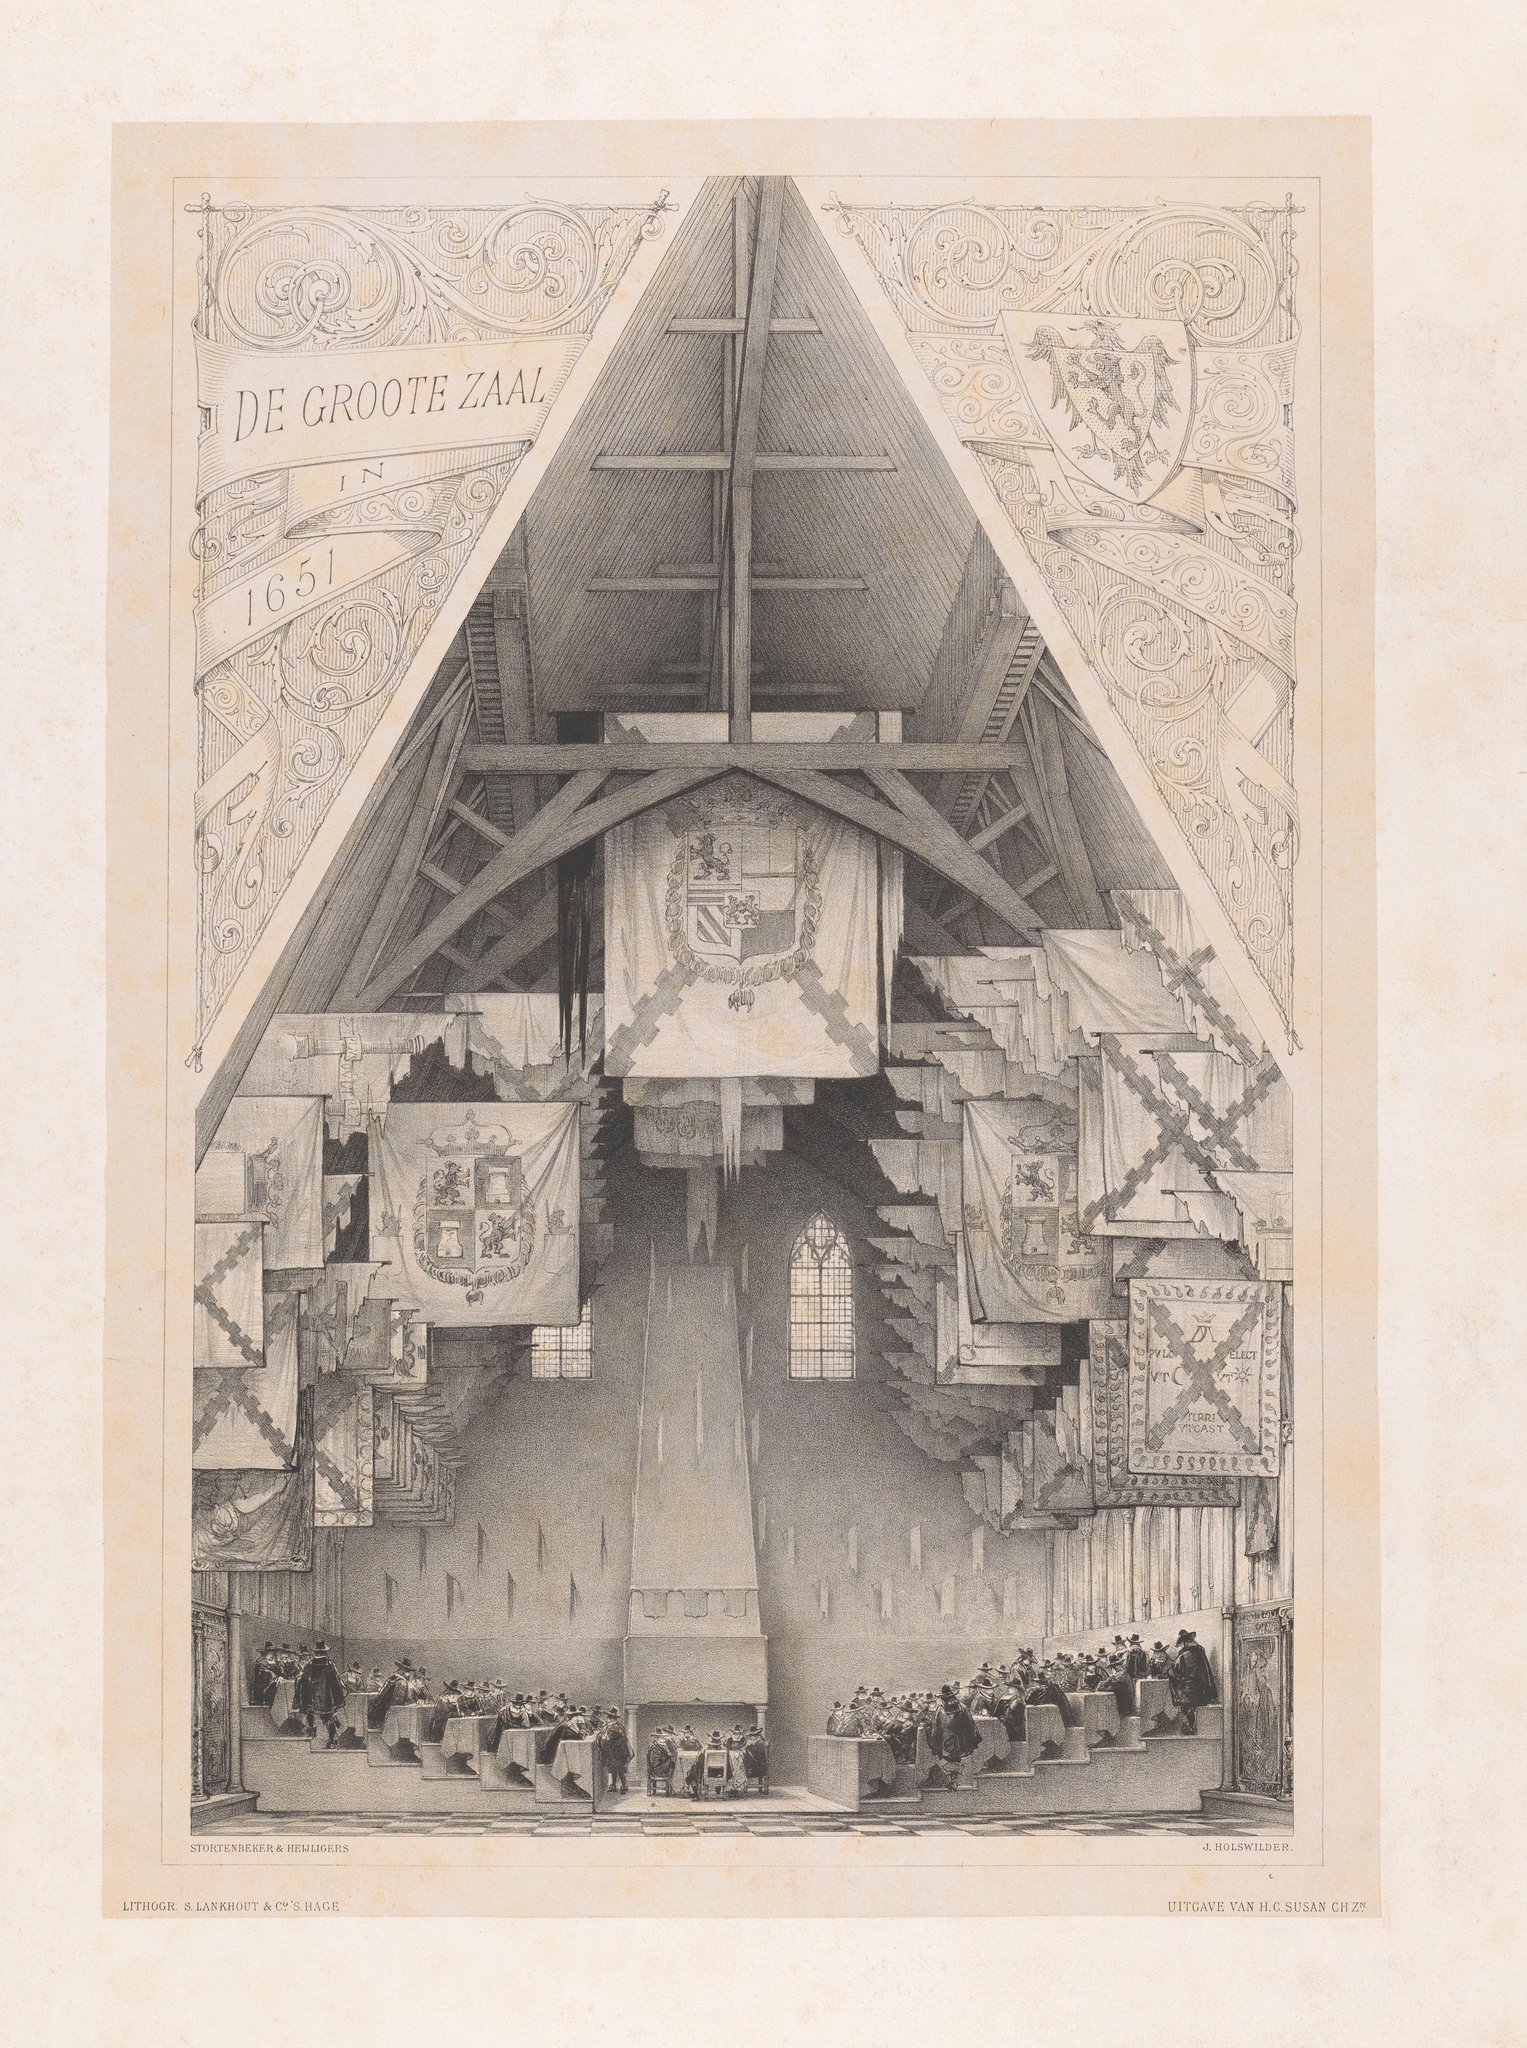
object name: print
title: Gezicht op het interieur van de Ridderzaal in 1651, op het Binnenhof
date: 1879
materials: paper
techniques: lithograph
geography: the hague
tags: national government